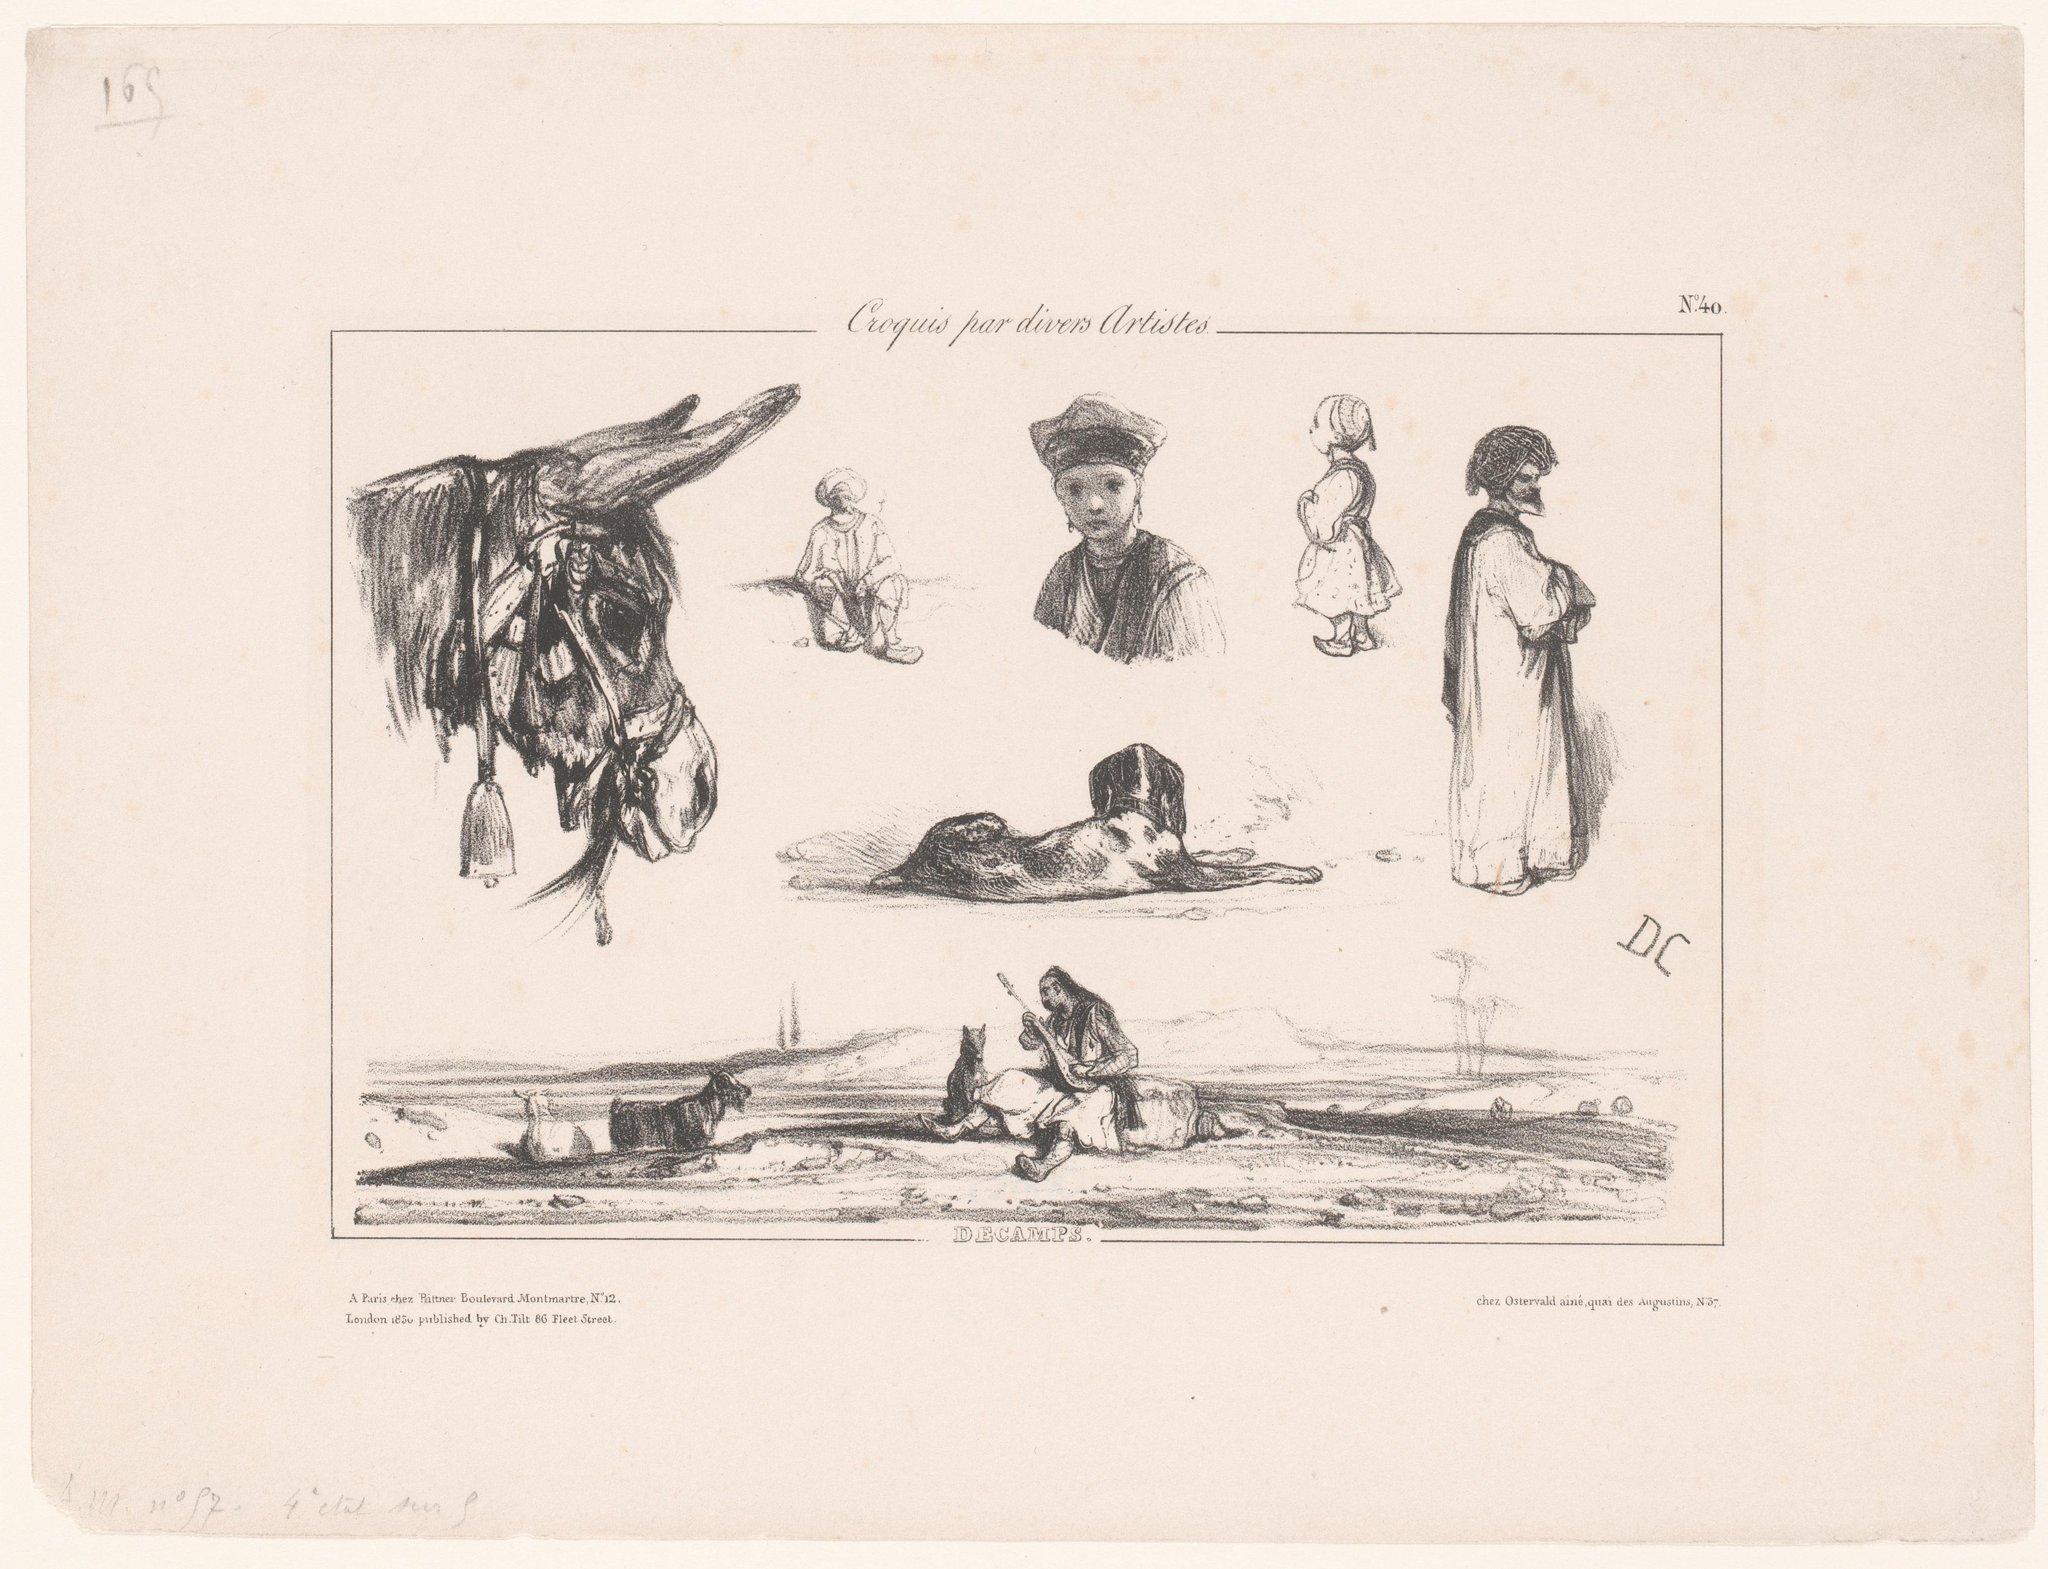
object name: print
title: Schetsen door diverse kunstenaars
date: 1830-1831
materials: paper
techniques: lithograph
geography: paris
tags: ass, donkey, herding, herdsman, herdswoman, shepherd, shepherdess, cowherd, etc.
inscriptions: number: Lugt 2228a